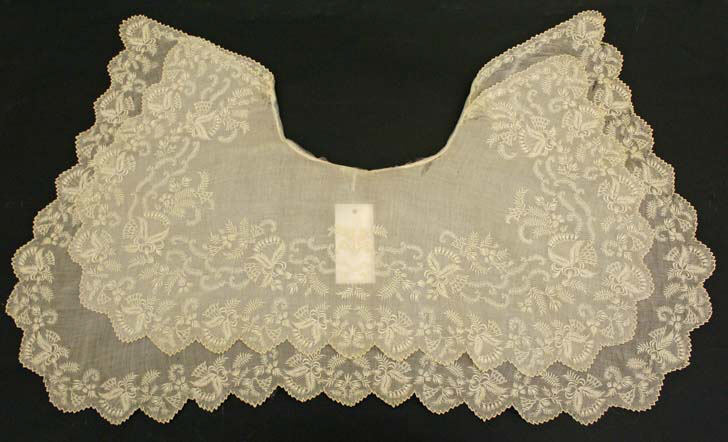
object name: double collar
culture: french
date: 1830-1839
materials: cotton